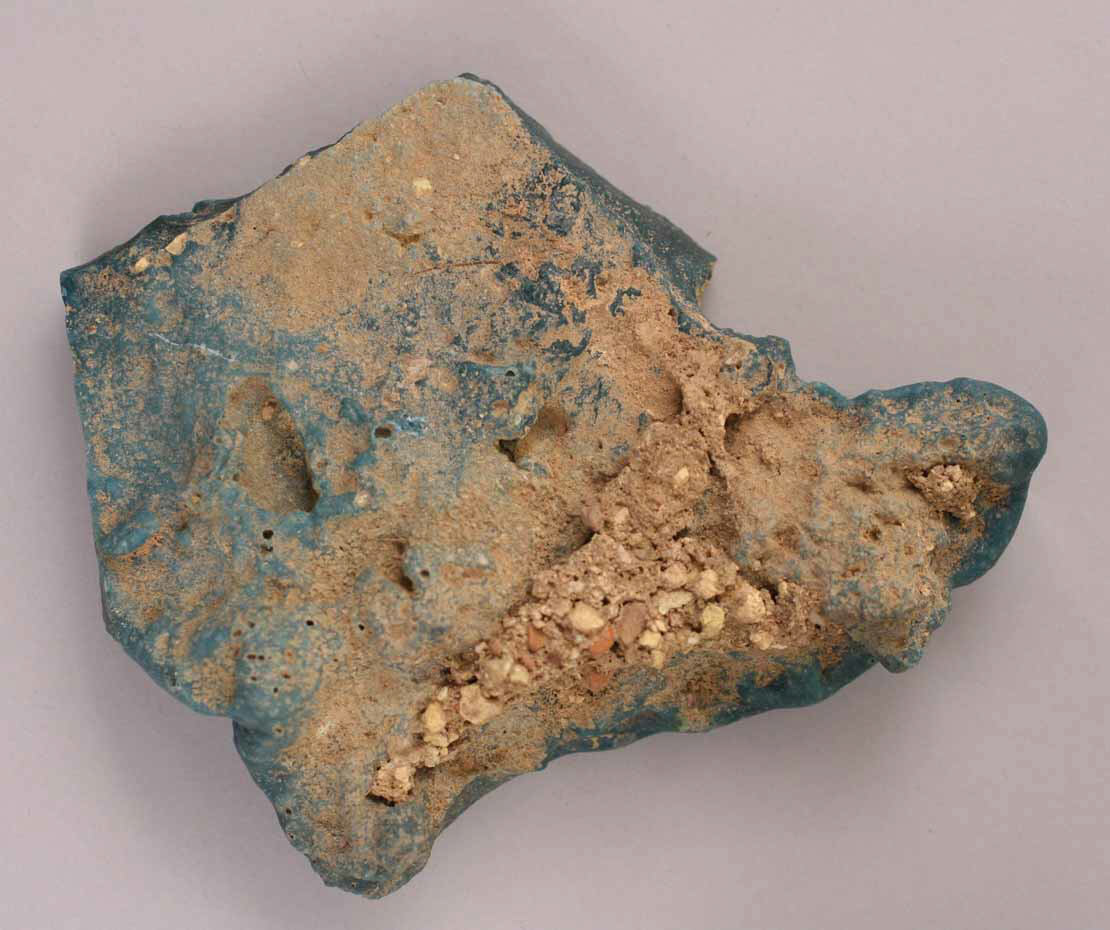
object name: fragment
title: Ceramic Fragment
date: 801-900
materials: glass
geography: iraq